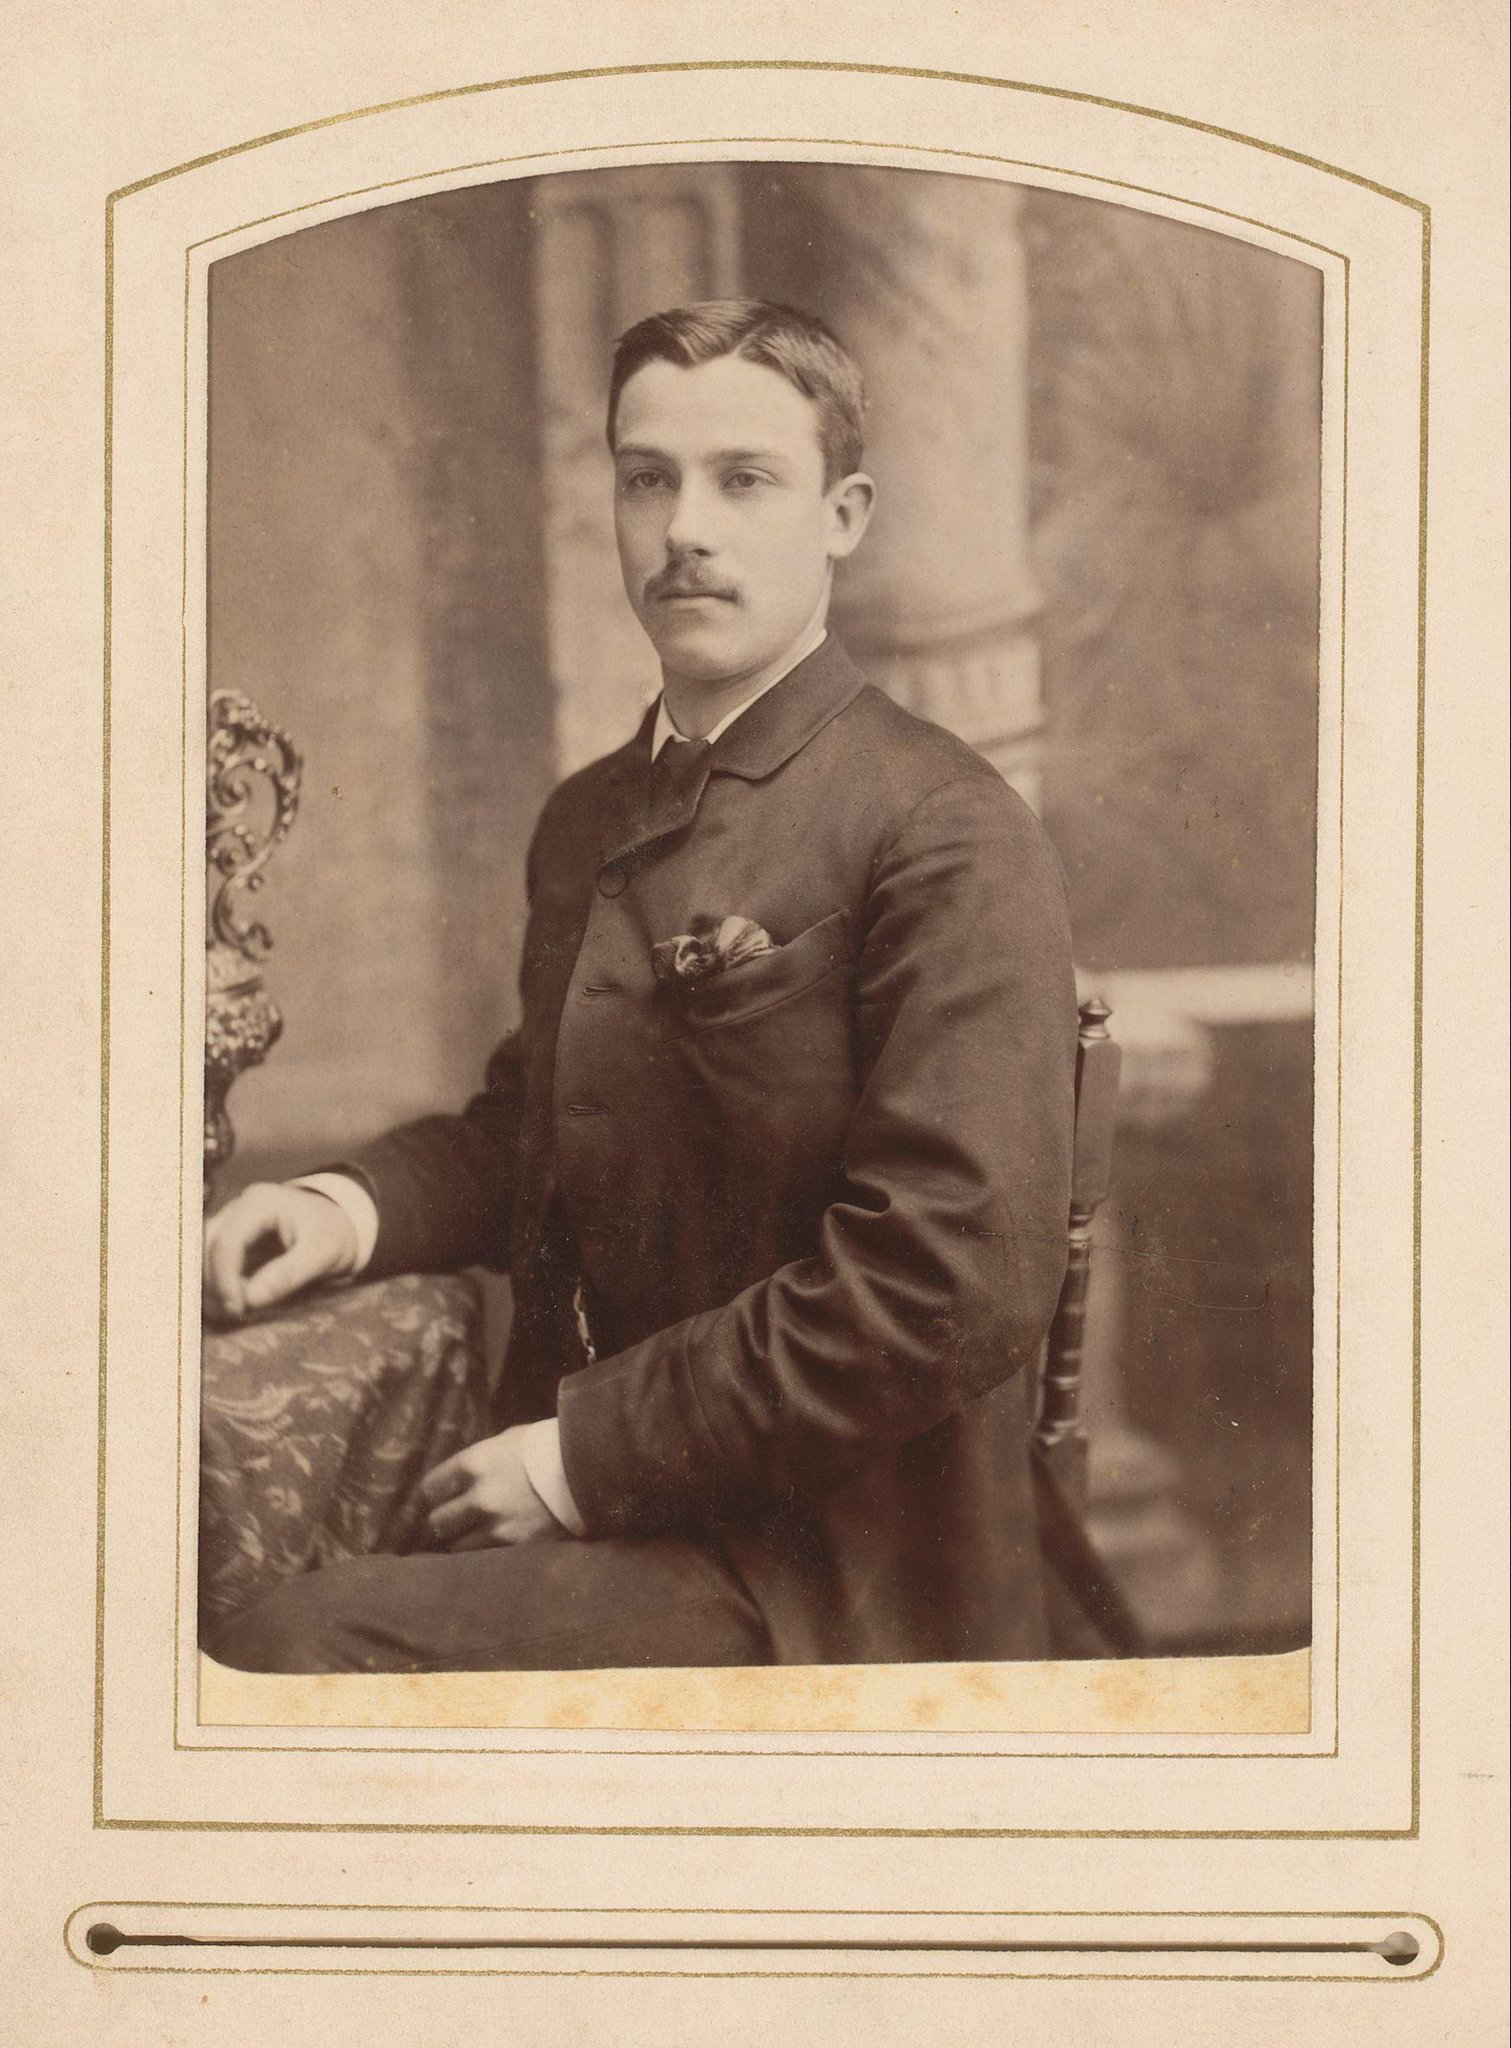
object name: photograph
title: Portret van een man met snor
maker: r.w. gibbs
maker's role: fotograaf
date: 1860-1900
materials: cardboard, photographic support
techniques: albumen print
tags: sitting figure, adult man, historical persons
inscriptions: check stamp: ‘[...]’, inscription: ‘From the studios/ of/ R.W. Gibbs & Co/20, Wilson Street/ Middlesboro/(...)’